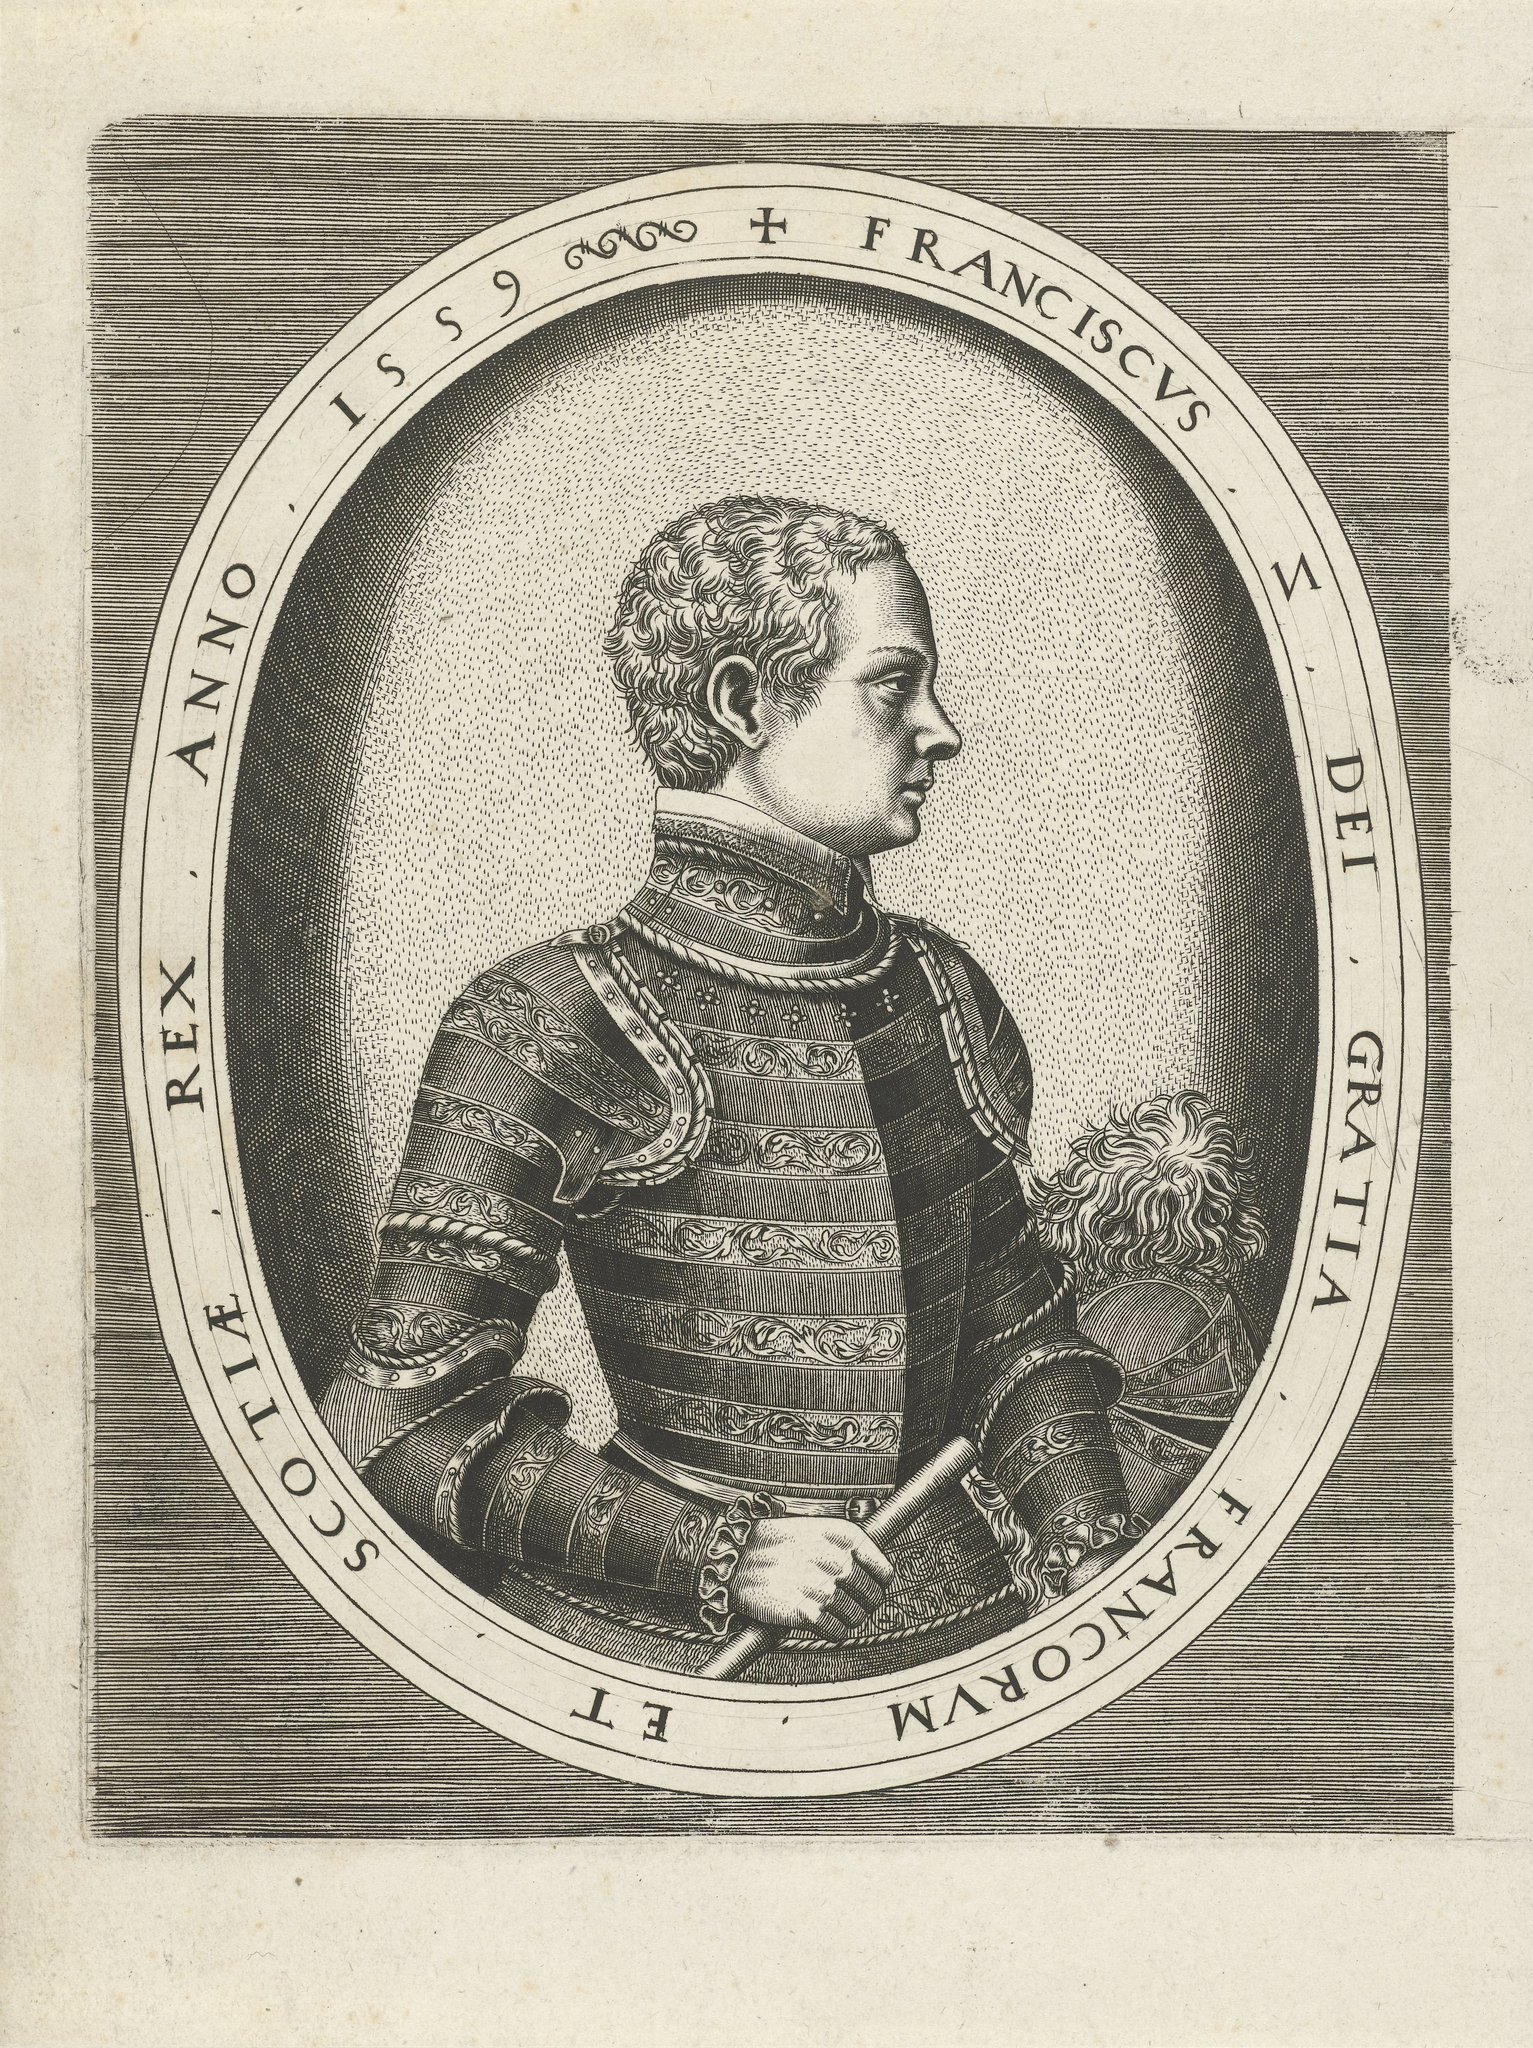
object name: print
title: Portretten van koningen, koninginnen, prinsen en prinsessen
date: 1559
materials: paper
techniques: engraving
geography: antwerp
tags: paris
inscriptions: collector's mark: Lugt 151, collector's mark: Lugt 2760, collector's mark: Lugt 2228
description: Portret van Frans II, koning van Frankrijk, ten halven lijve naar rechts met een bevelhebberstaf in zijn hand, rechts op de achtergrond een helm, in een ovale lijst met randschrift in het Latijn.